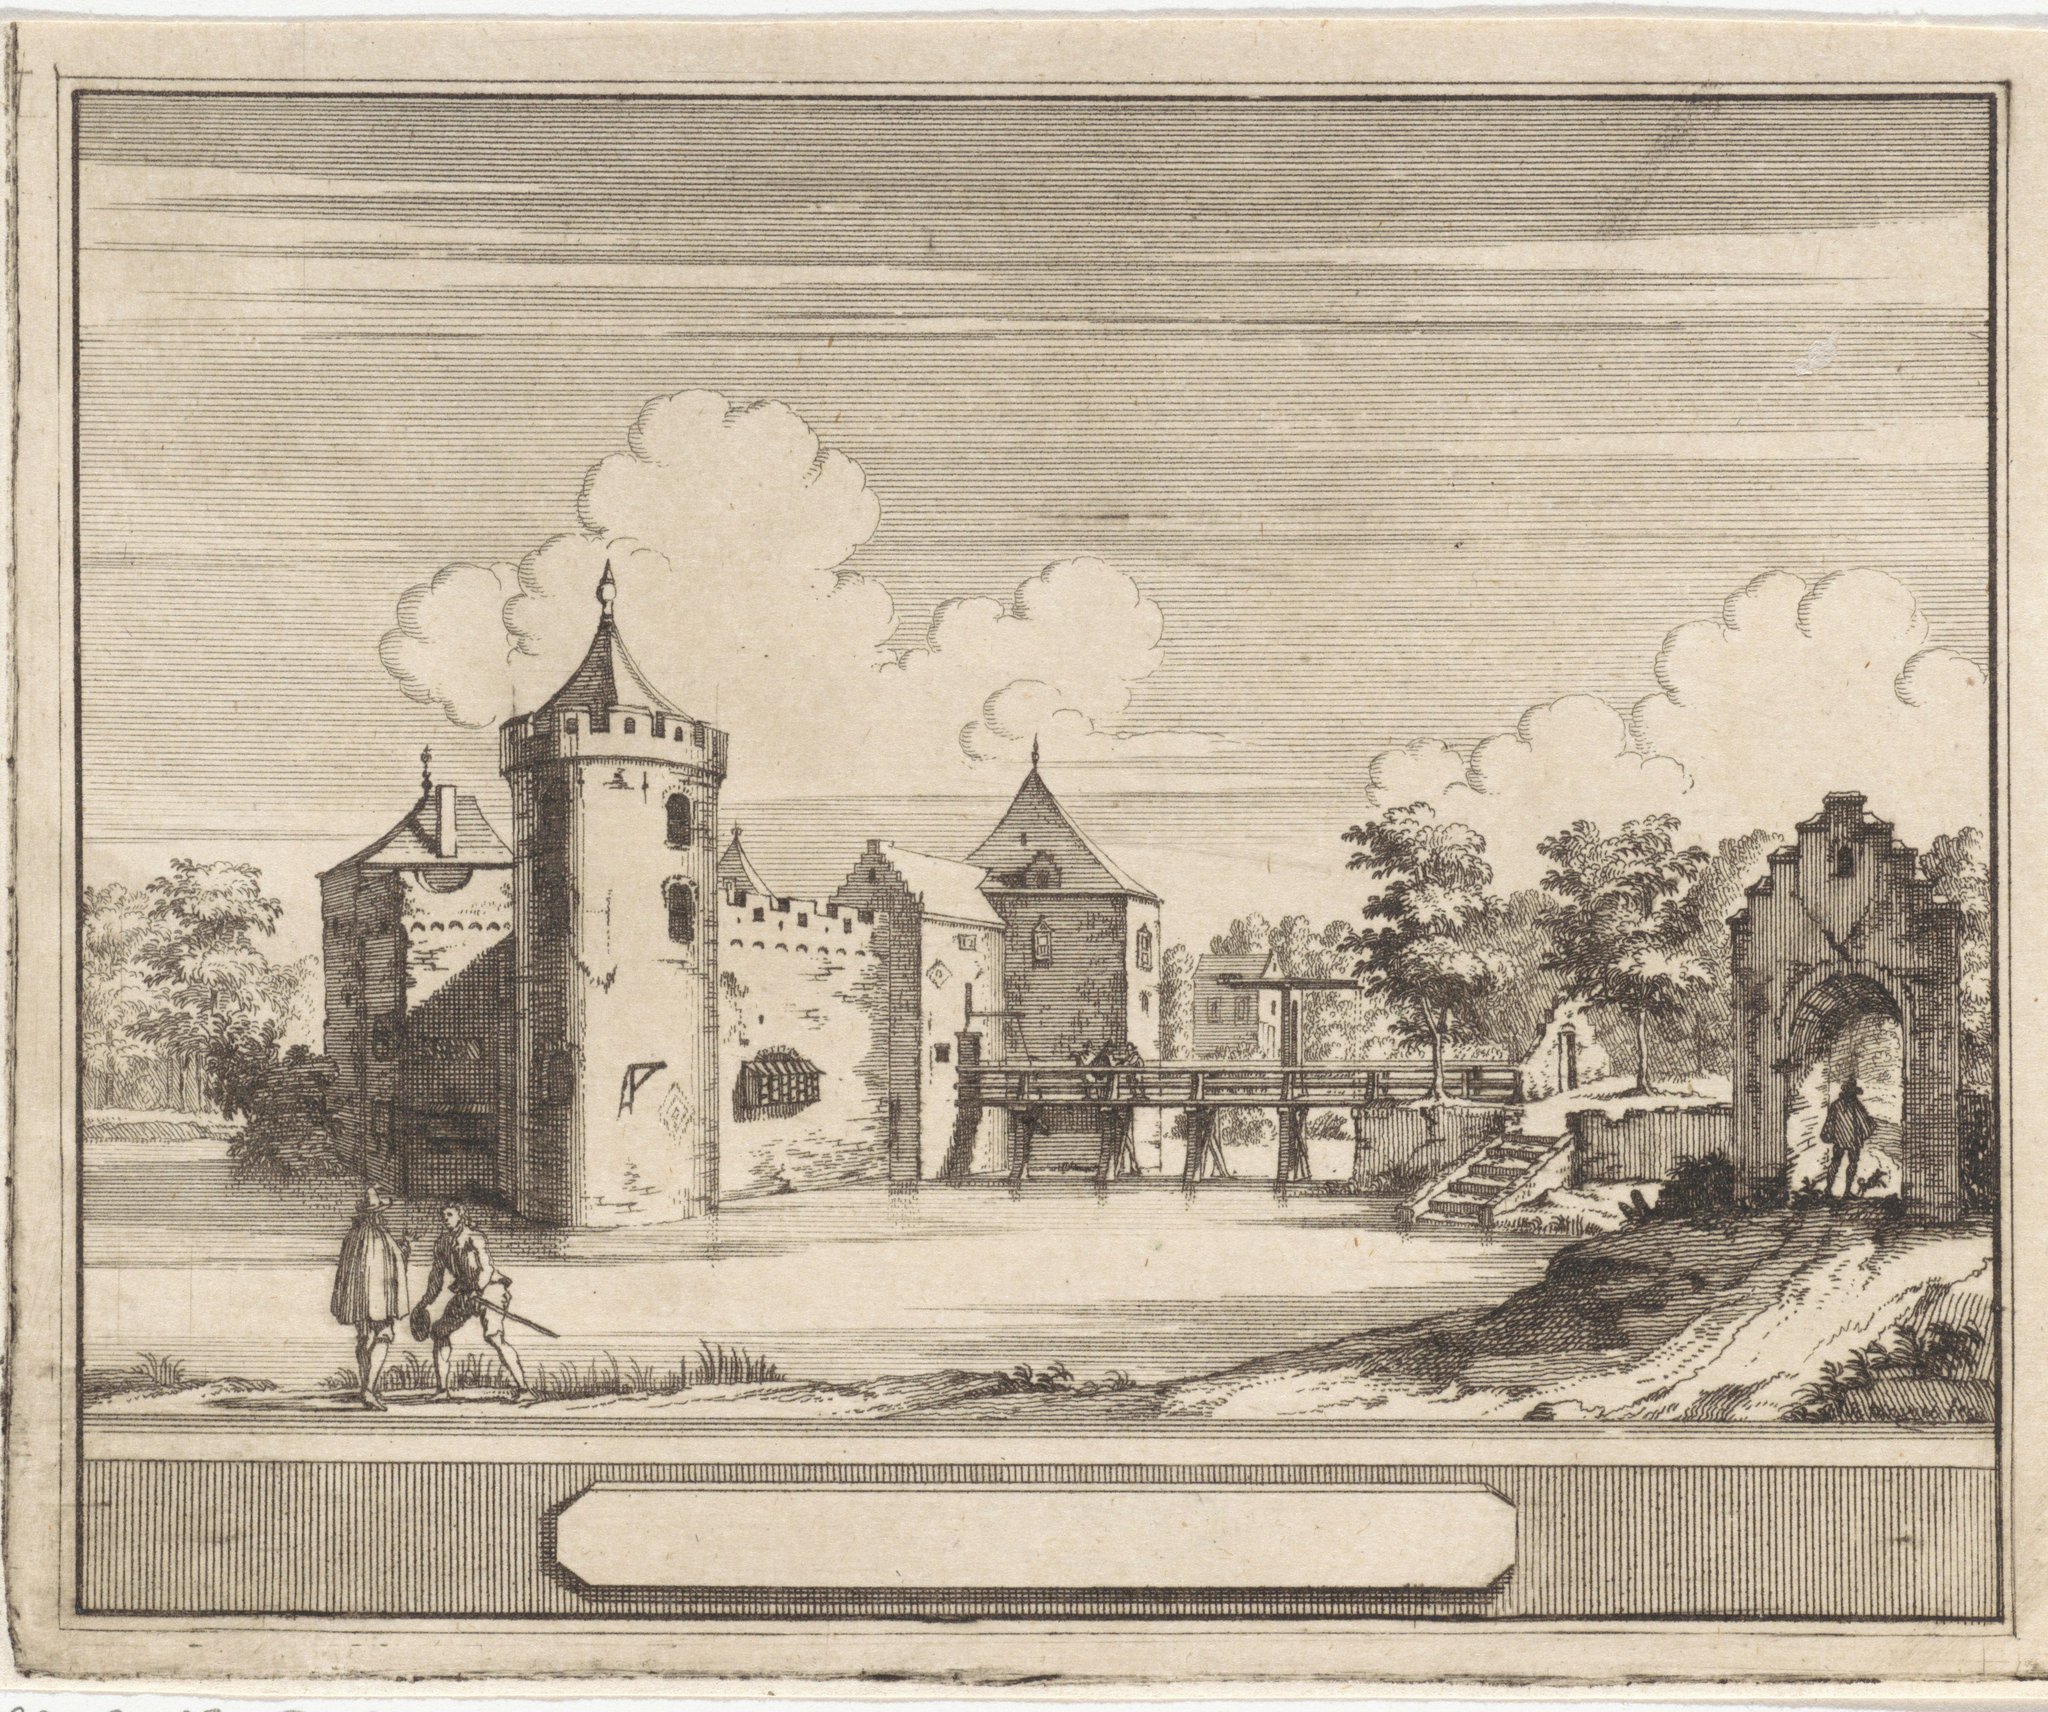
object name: print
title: Gezicht op het kasteel te Abcoude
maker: jacobus schijnvoet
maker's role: draughtsman, print maker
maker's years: 1685-1743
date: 1711-1774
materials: paper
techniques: etching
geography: amsterdam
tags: castle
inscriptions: collector's mark: Lugt 2228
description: Latere staat van deze prent als illustratie opgenomen in: Smids, Ludolph. Schatkamer der Nederlandsse[!] oudheden; of Woordenboek, behelsende Nederlands steden, Amsterdam: Pieter de Coup, 1711. Verscheen tevens in de heruitgave van voorgenoemd werk in 1737 en 1774. In 1721 verscheen er een uitgave met alleen de prenten: Nederlandsche oudheden, bestaande in zestig verbeeldingen (...) gelegen in Holland, 't Sticht van Utrecht en Gelderland enz. Amsterdam: Hendrik Bosch, 1721.